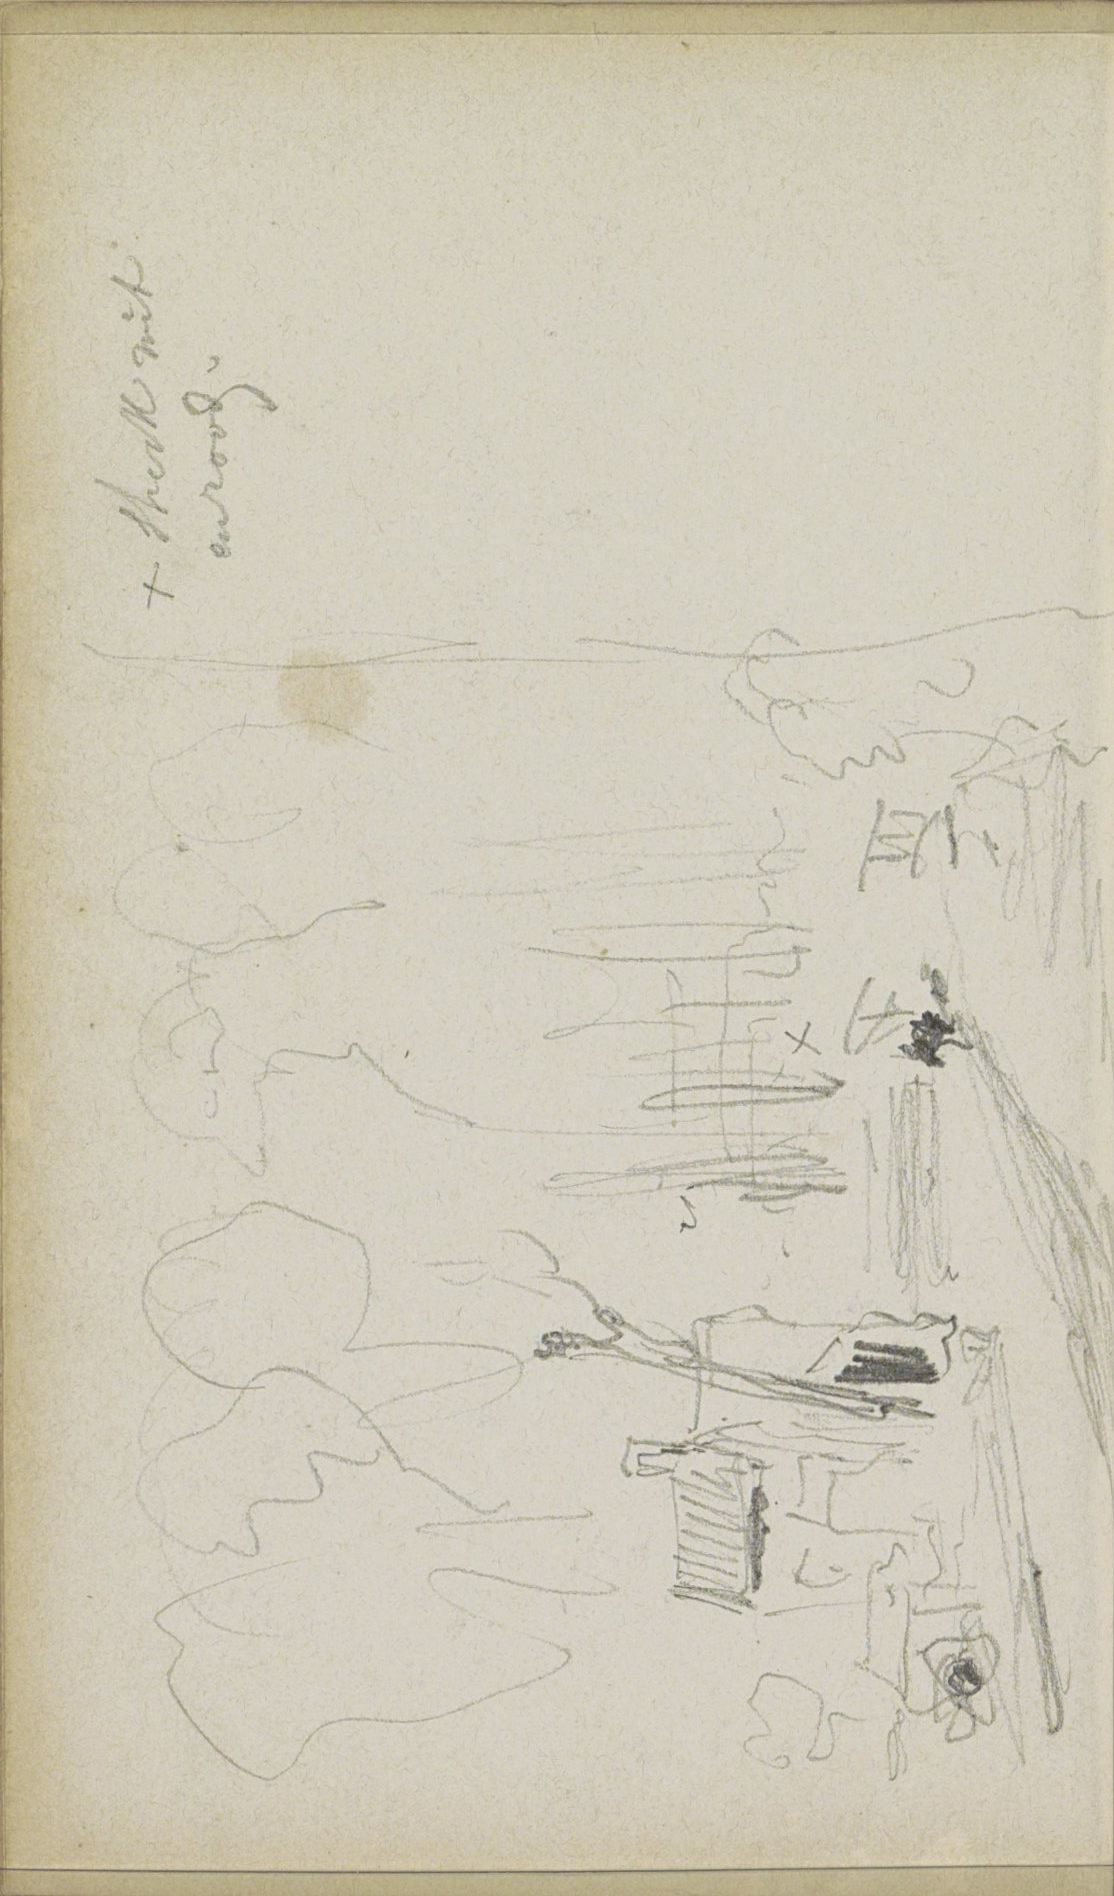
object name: sketchbook leaf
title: Gezicht op een landweg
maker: adrianus eversen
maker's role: draughtsman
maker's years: 1818-1897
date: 1828-1897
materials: paper, pencil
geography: netherlands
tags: trees, road, path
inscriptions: kleurnotitie, handgeschreven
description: Een landweg leidt naar een groep bomen. Links een gebouw. In het midden een brug. Blad 19 verso uit een schetsboek met 69 bladen vervaardigd in de omgeving van Delft, Rotterdam, Oudewater en Harlingen.